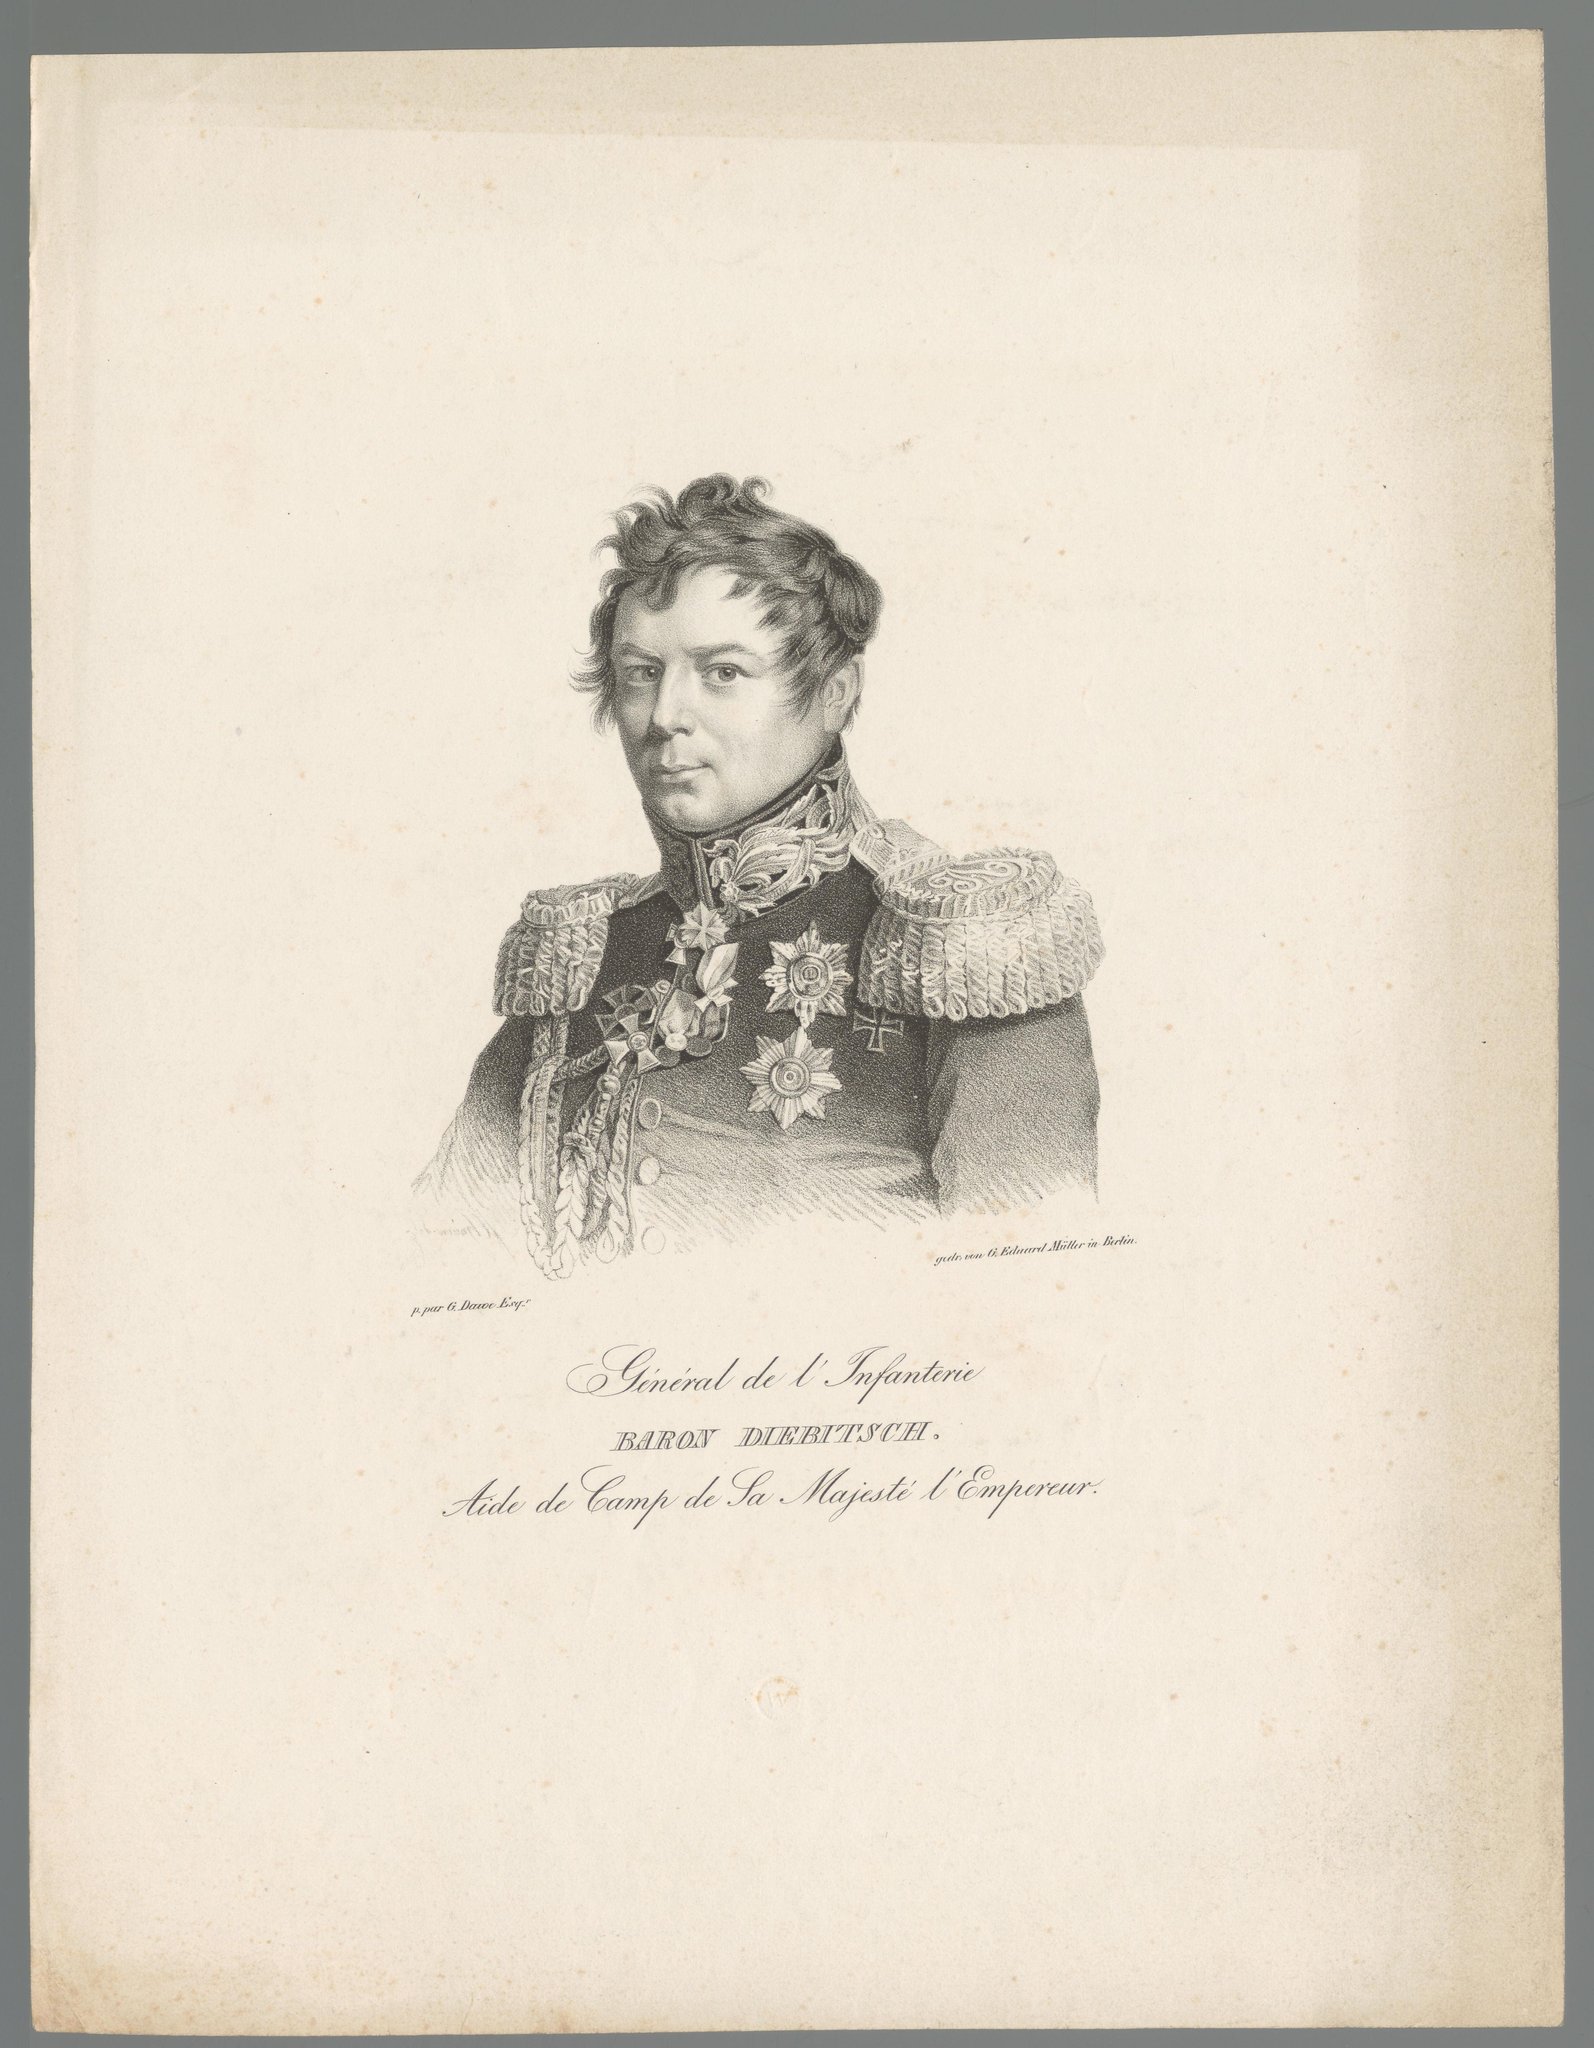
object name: print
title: Général de l'Infanterie Baron Diebitsch, Aide de Camp de la Majesté l'Empereur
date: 1830-1840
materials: paper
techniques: lithograph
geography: germany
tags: adult man, historical persons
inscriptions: check stamp: Lugt 2595b, collector's mark: Lugt 2228